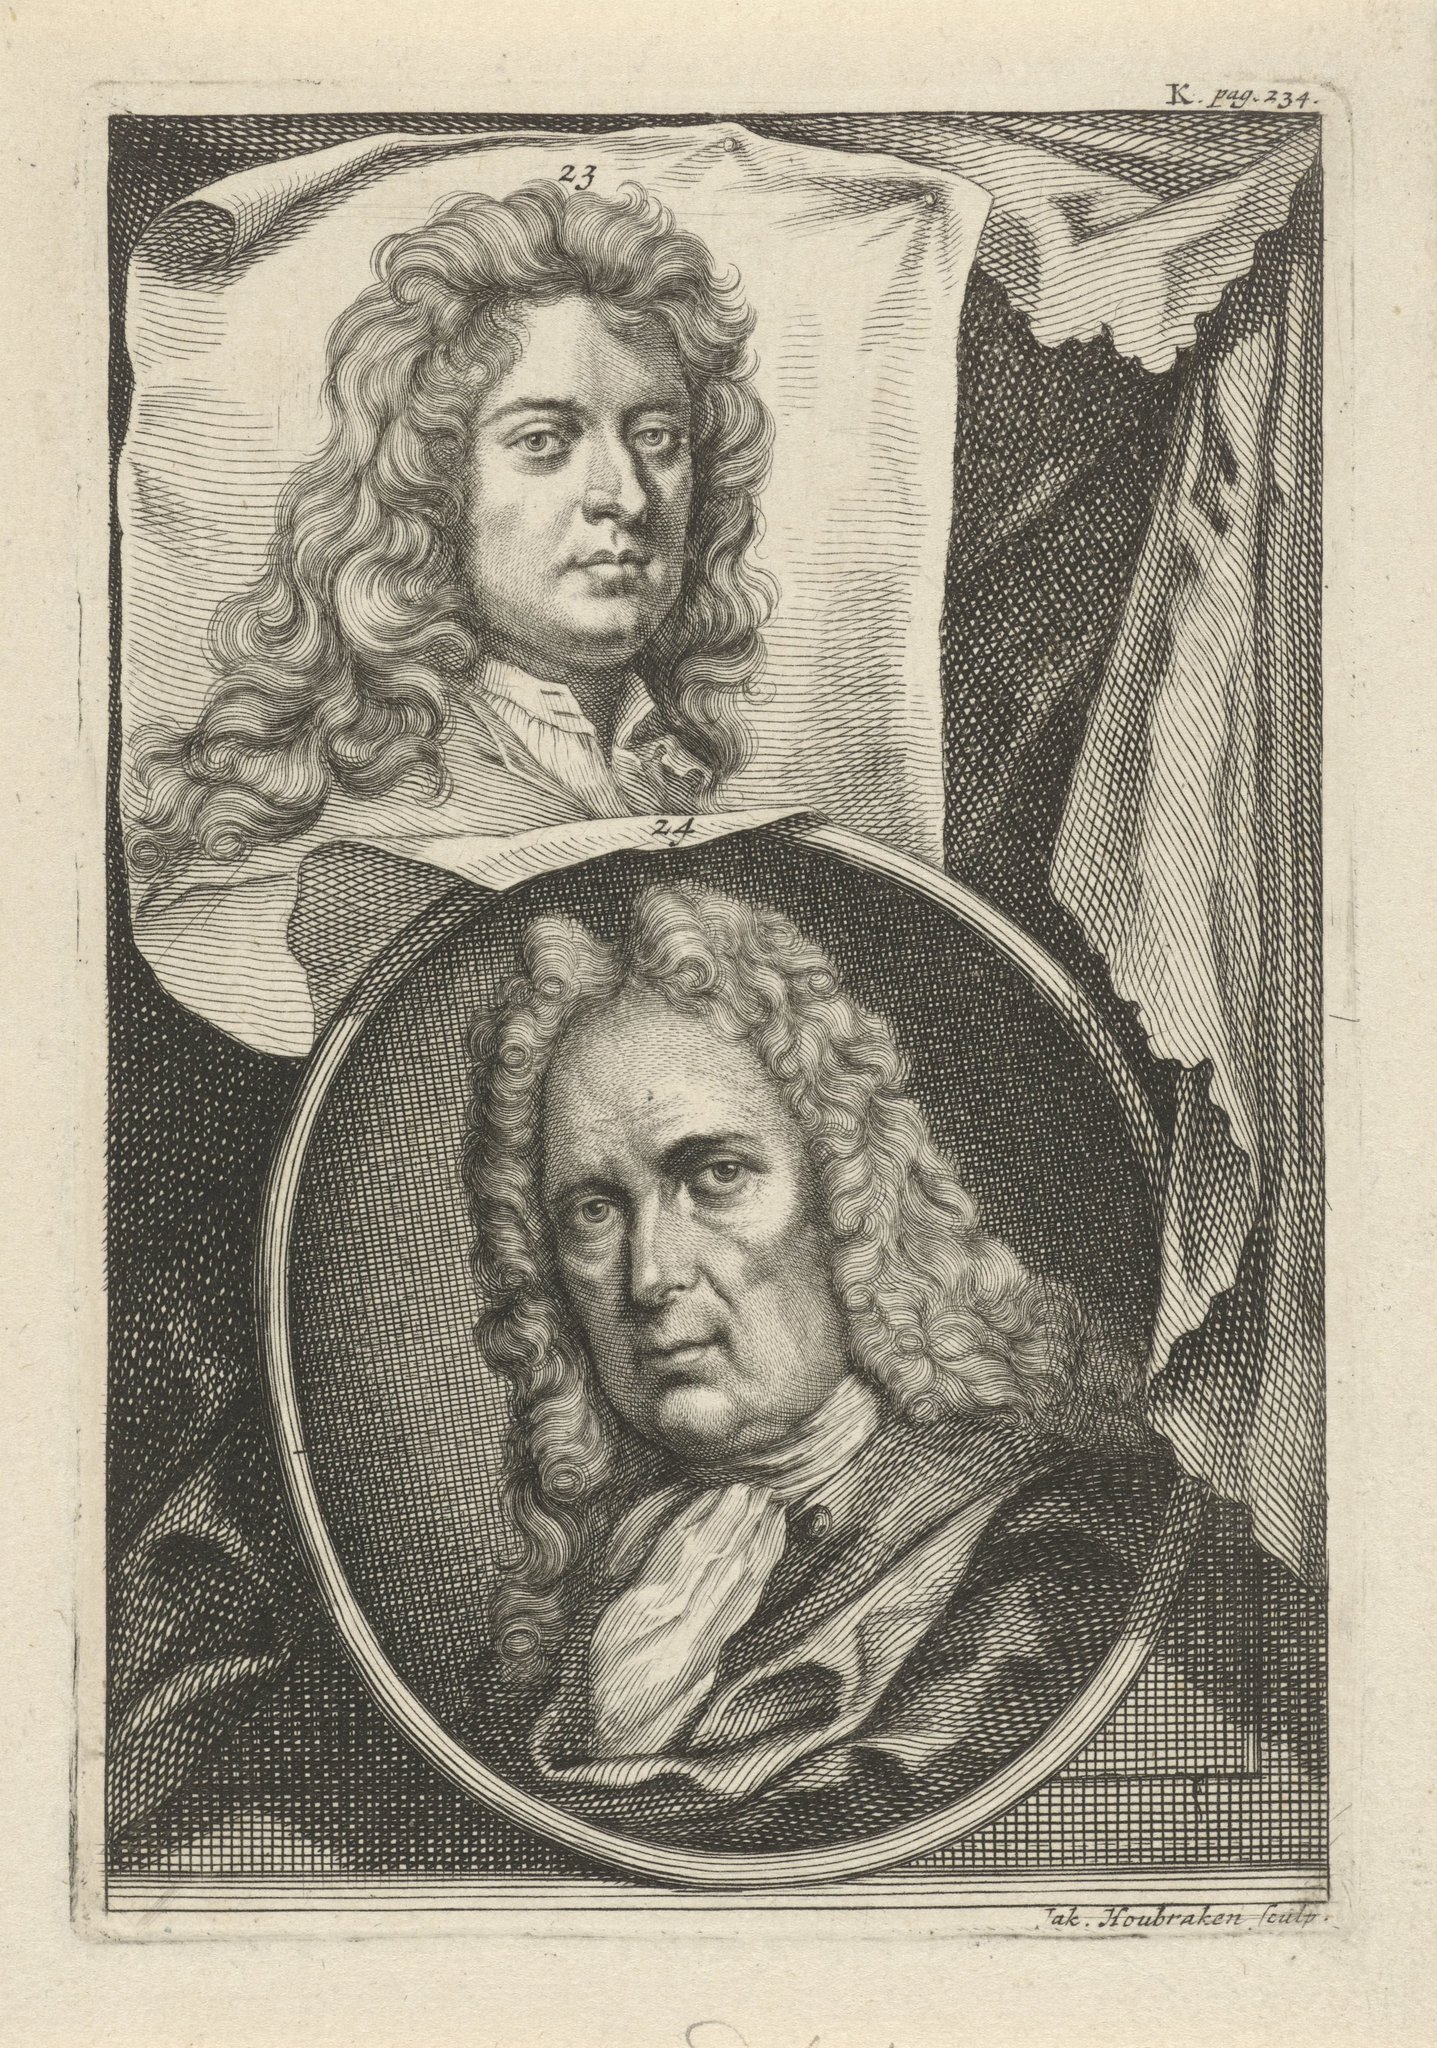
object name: book illustration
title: Portretten van Gottfried Kneller en Gerard Hoet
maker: jacob houbraken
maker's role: draughtsman, print maker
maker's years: 1698-1780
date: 1721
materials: paper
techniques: engraving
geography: amsterdam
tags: london, gottfried kneller, the hague, painter, print maker, draughtsman, gerard hoet (i)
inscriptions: collector's mark: Lugt 2228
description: Prent ook gebruikt in: Arnold Houbraken. De groote Schouburgh der Nederlantsche konstschilders en schilderessen : waar van 'er vele met hunne beeltenissen ten tooneel verschynen, ... zynde een vervolg op het Schilderboek van K. van Mander. 3 dln. Eerste druk. Amsterdam: 1718-1721.